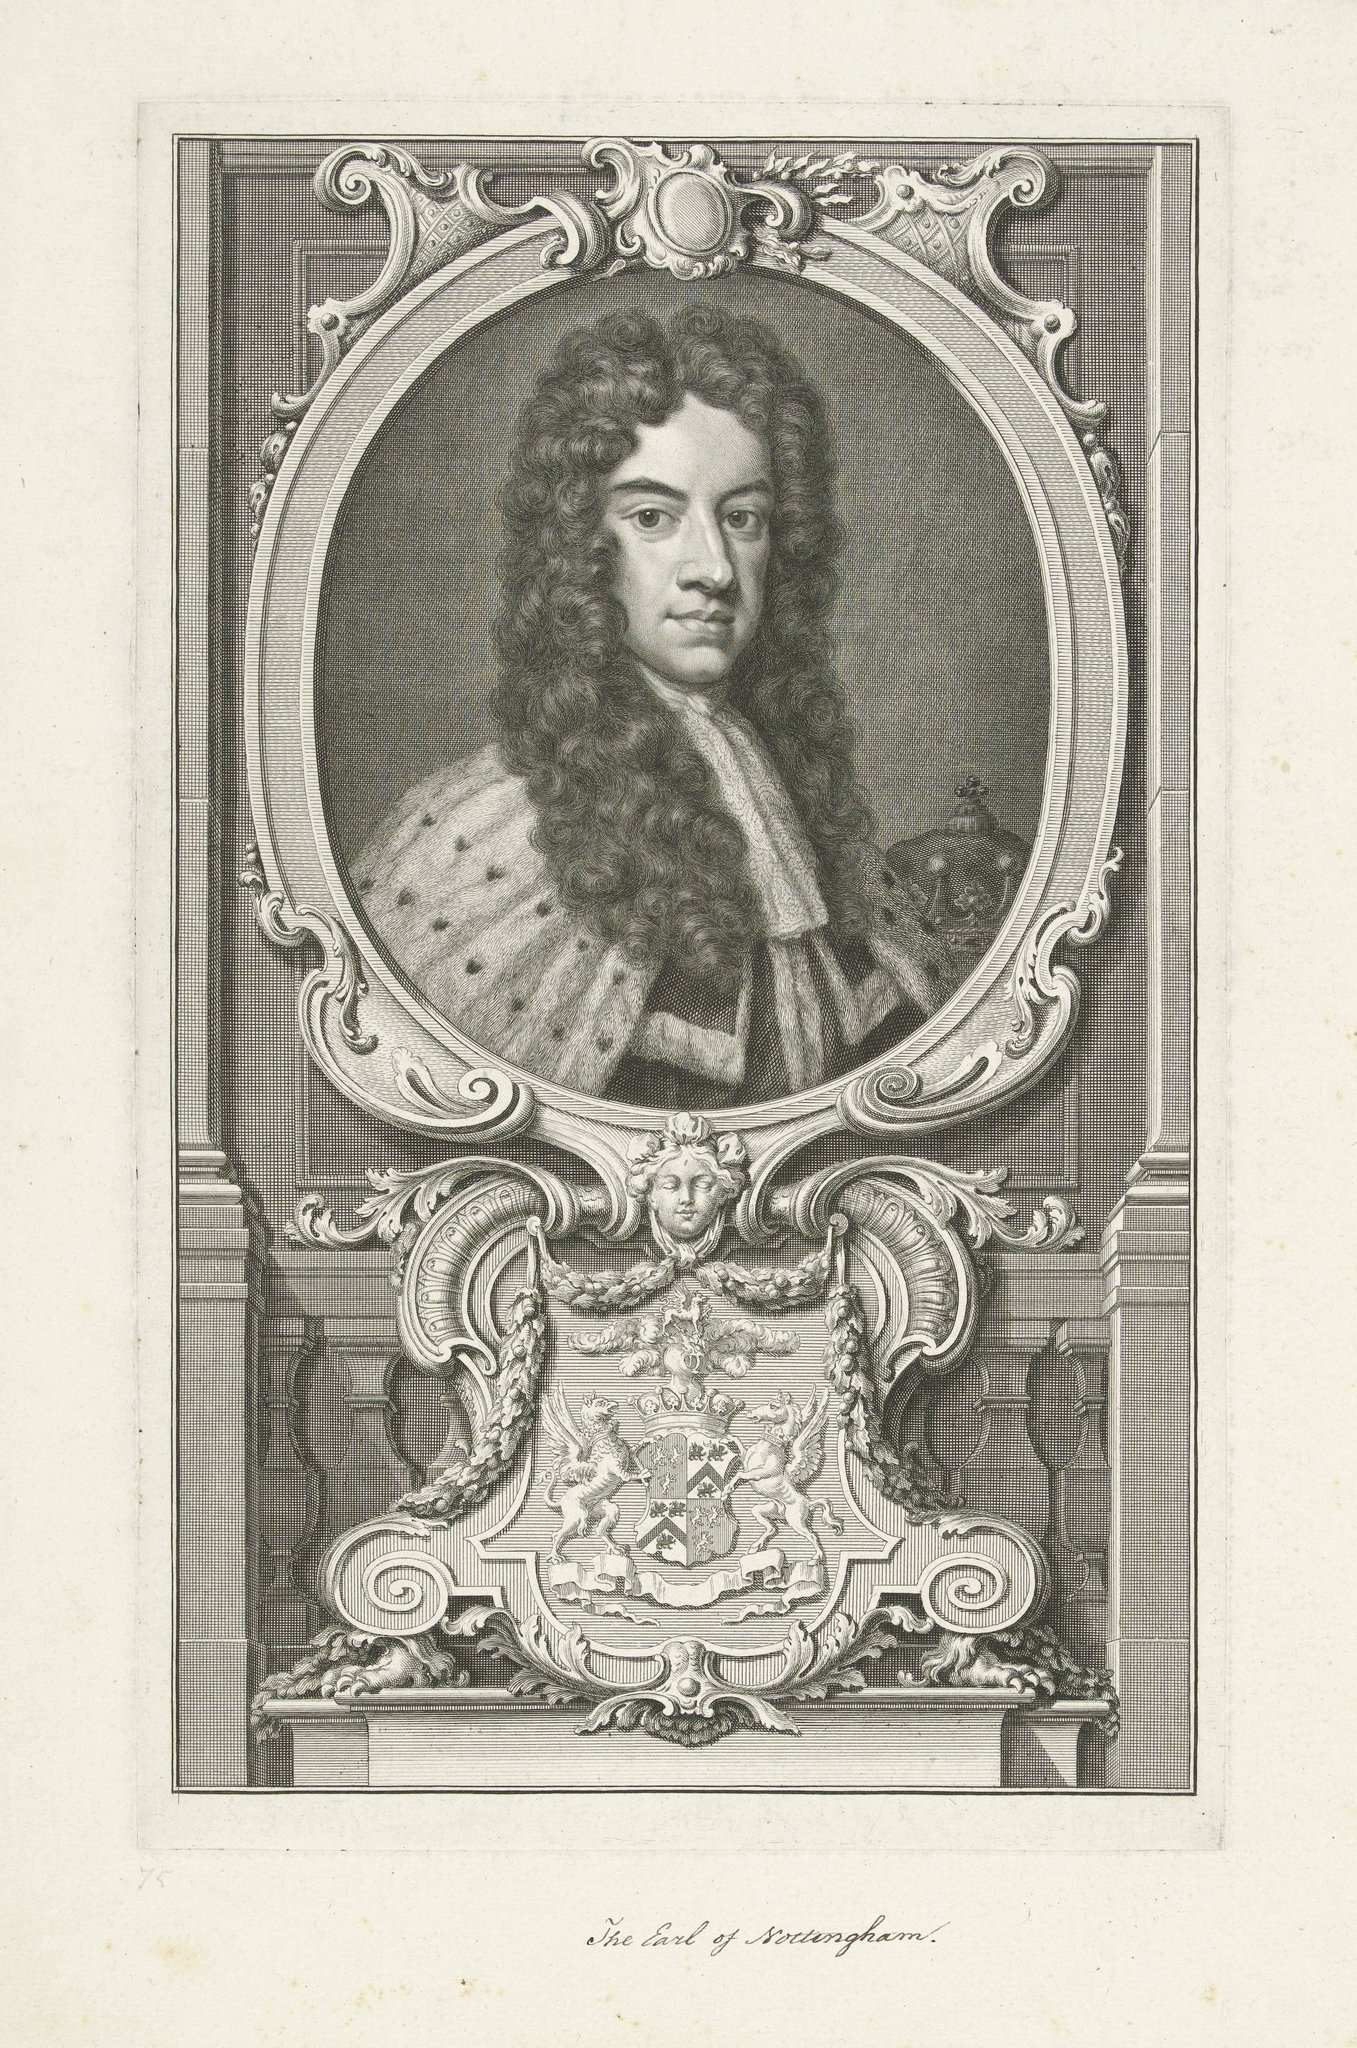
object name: print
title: Portret van Daniel Finch, 2e graaf van Nottingham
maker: jacob houbraken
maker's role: draughtsman, print maker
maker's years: 1698-1780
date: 1741-1743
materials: paper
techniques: engraving, etching, pen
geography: amsterdam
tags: staatsman, daniel finch (2e graaf van nottingham)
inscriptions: collector's mark: Lugt 240, name: ‘The Earl of Nottingham’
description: Prent ook gebruikt in: Thomas Birch. The heads of illustrious persons of Great Britain : engraved by Houbraken, and Vertue, with their lives and characters. London: John en Paul Knapton, 1743-1751.